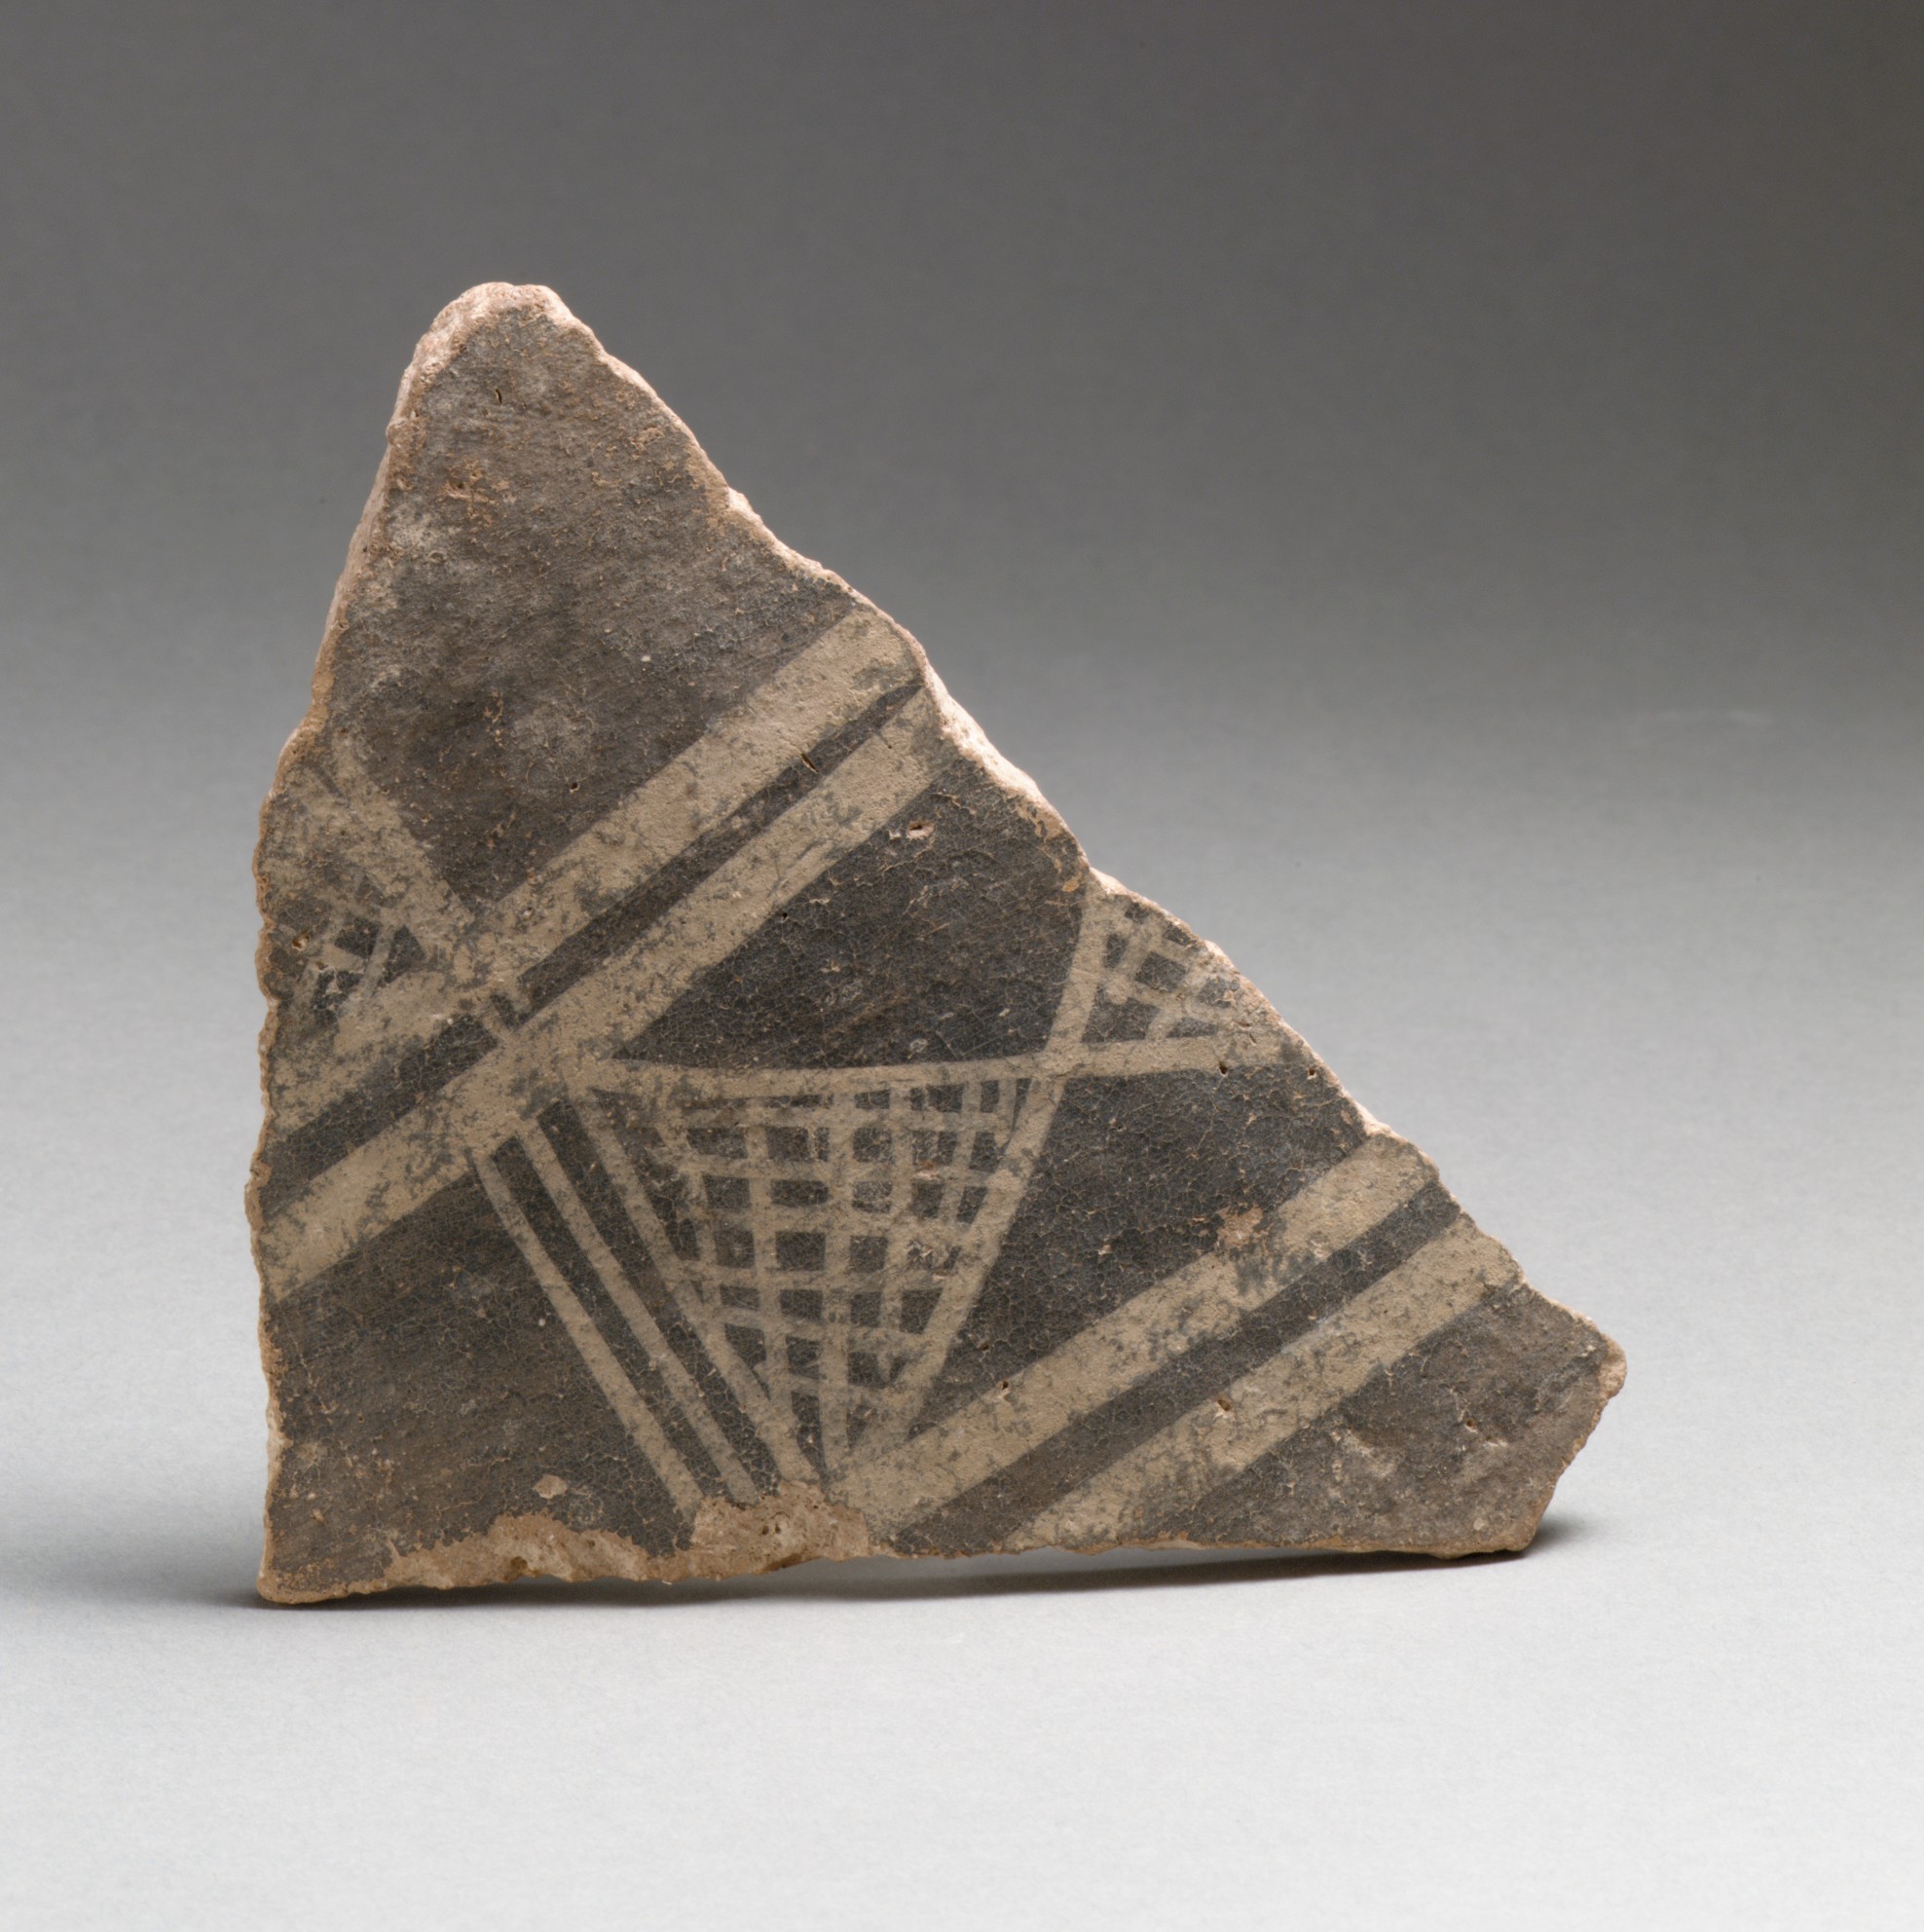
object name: vase fragment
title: Terracotta vessel fragment with cross-hatched triangles and broad bands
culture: minoan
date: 2300-2100 BCE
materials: terracotta